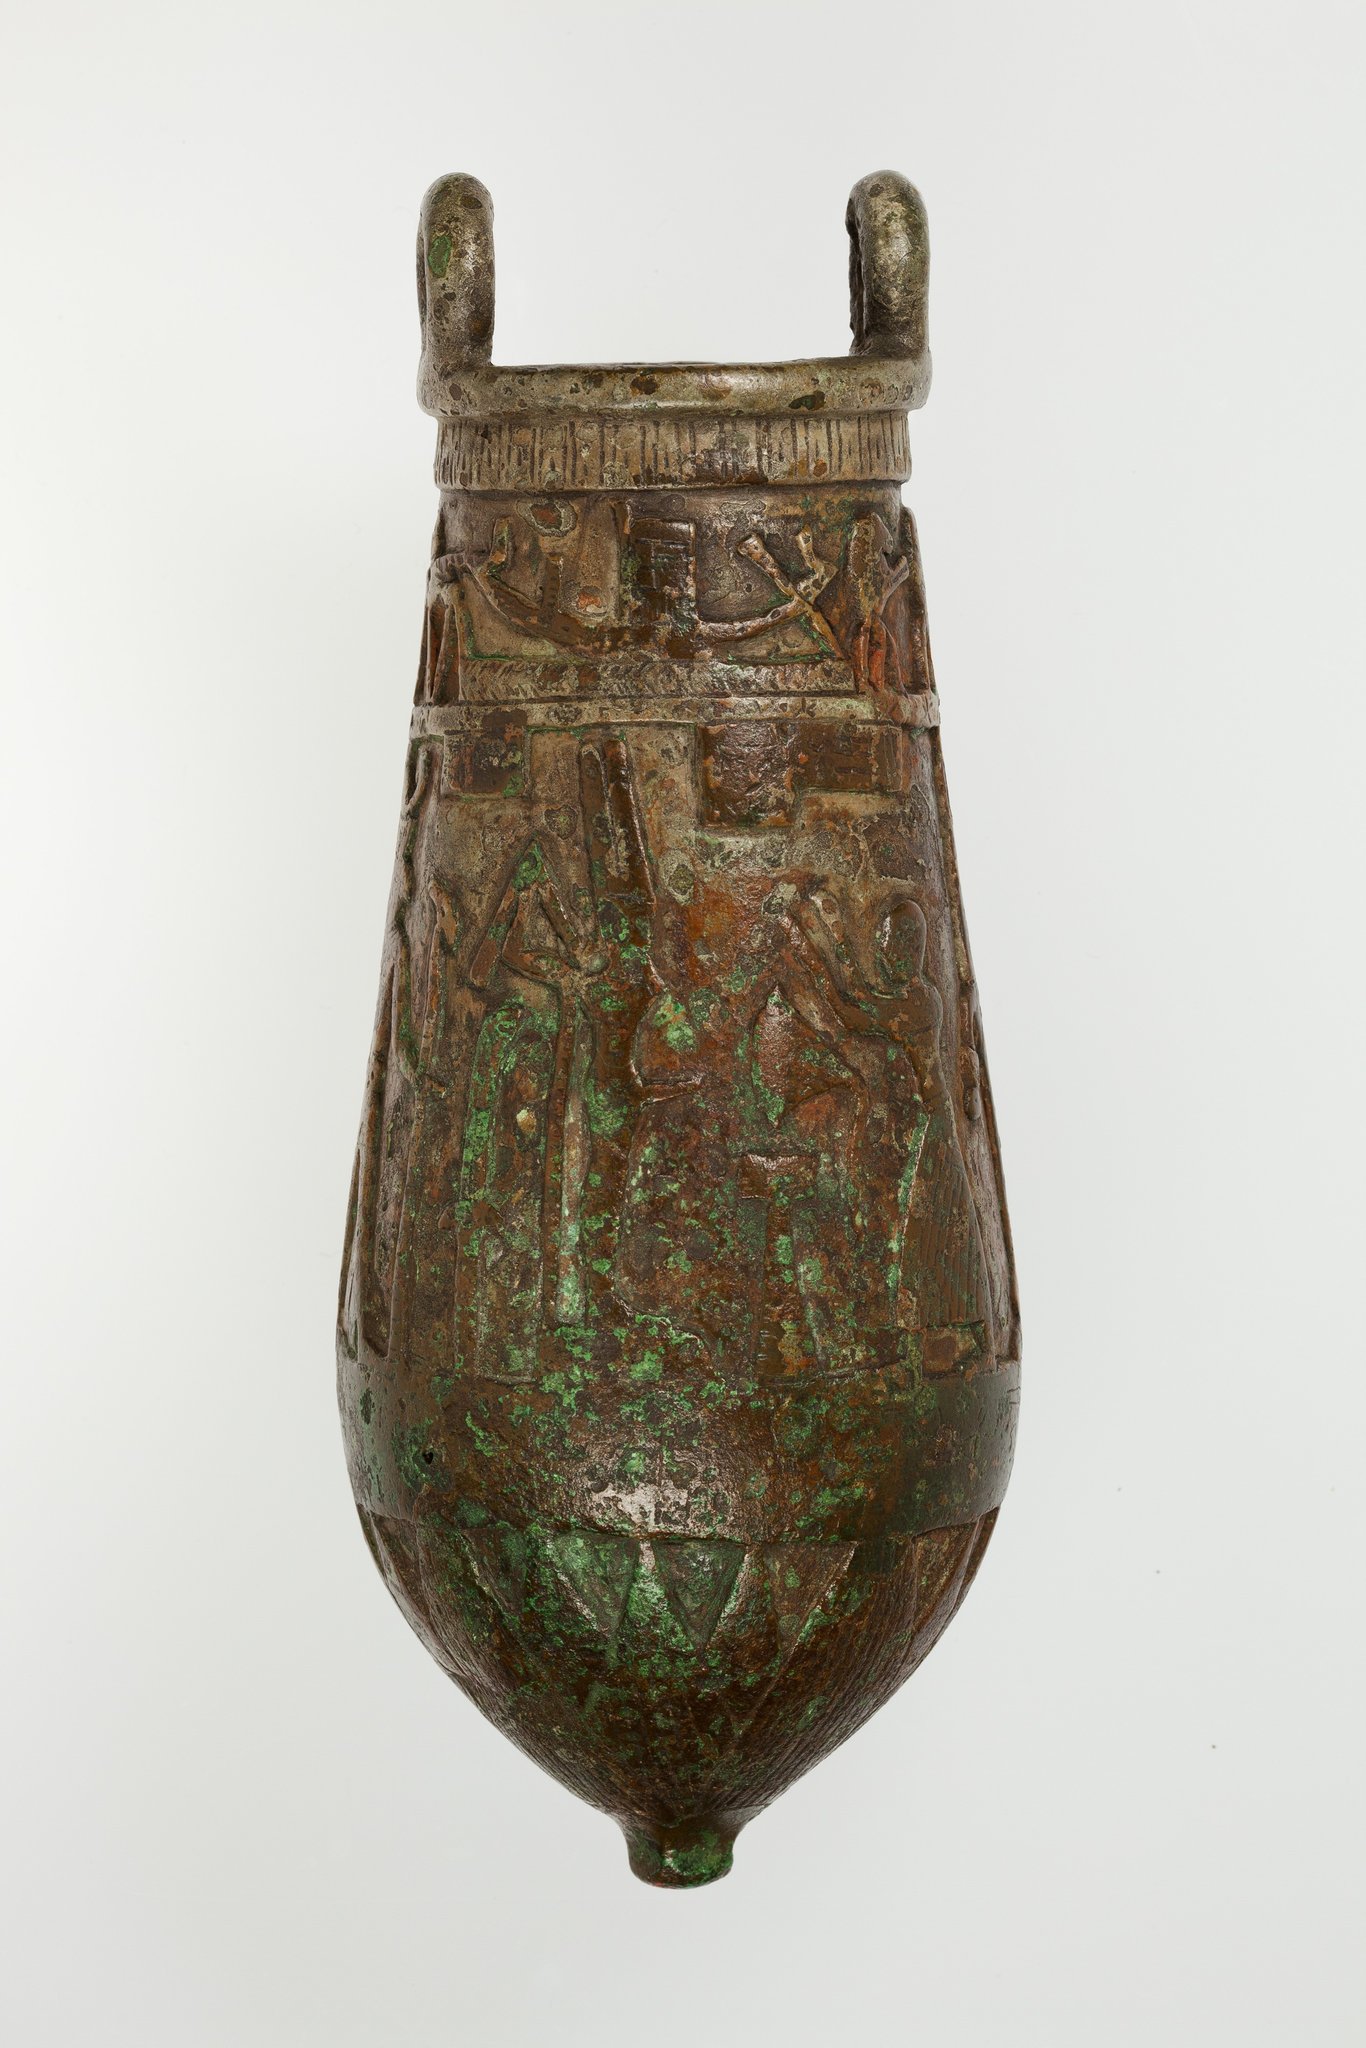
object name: situla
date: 600 BCE-100 CE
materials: copper alloy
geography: egypt